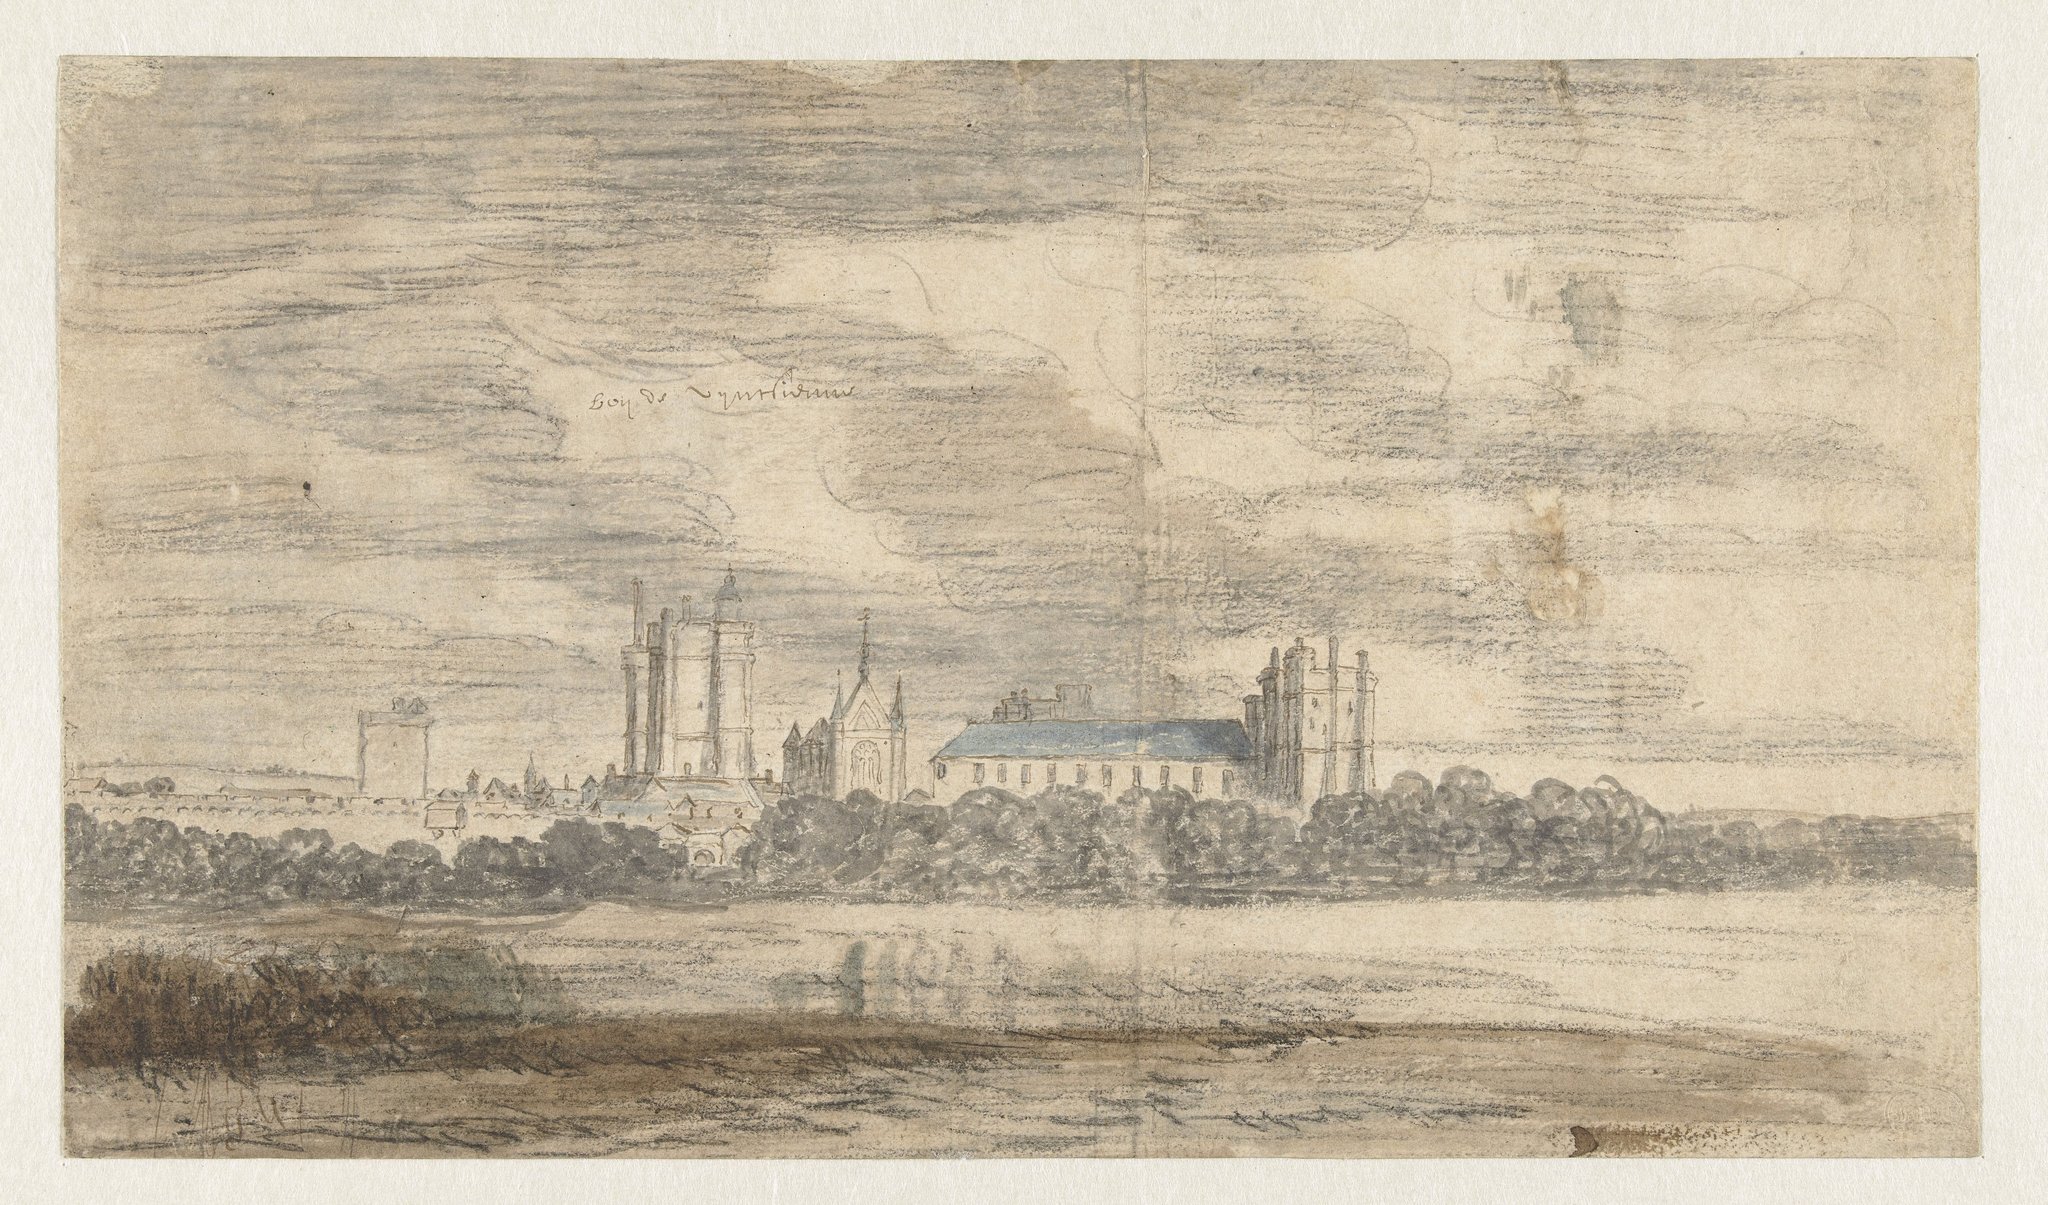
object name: drawing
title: Gezicht op het kasteel van Vincennes, achter een rij bomen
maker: abraham de verwer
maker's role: draughtsman, painter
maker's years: 1585-1650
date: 1600-1650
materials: chalk, ink, paper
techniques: brush, pen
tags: castle, farm or solitary house in landscape